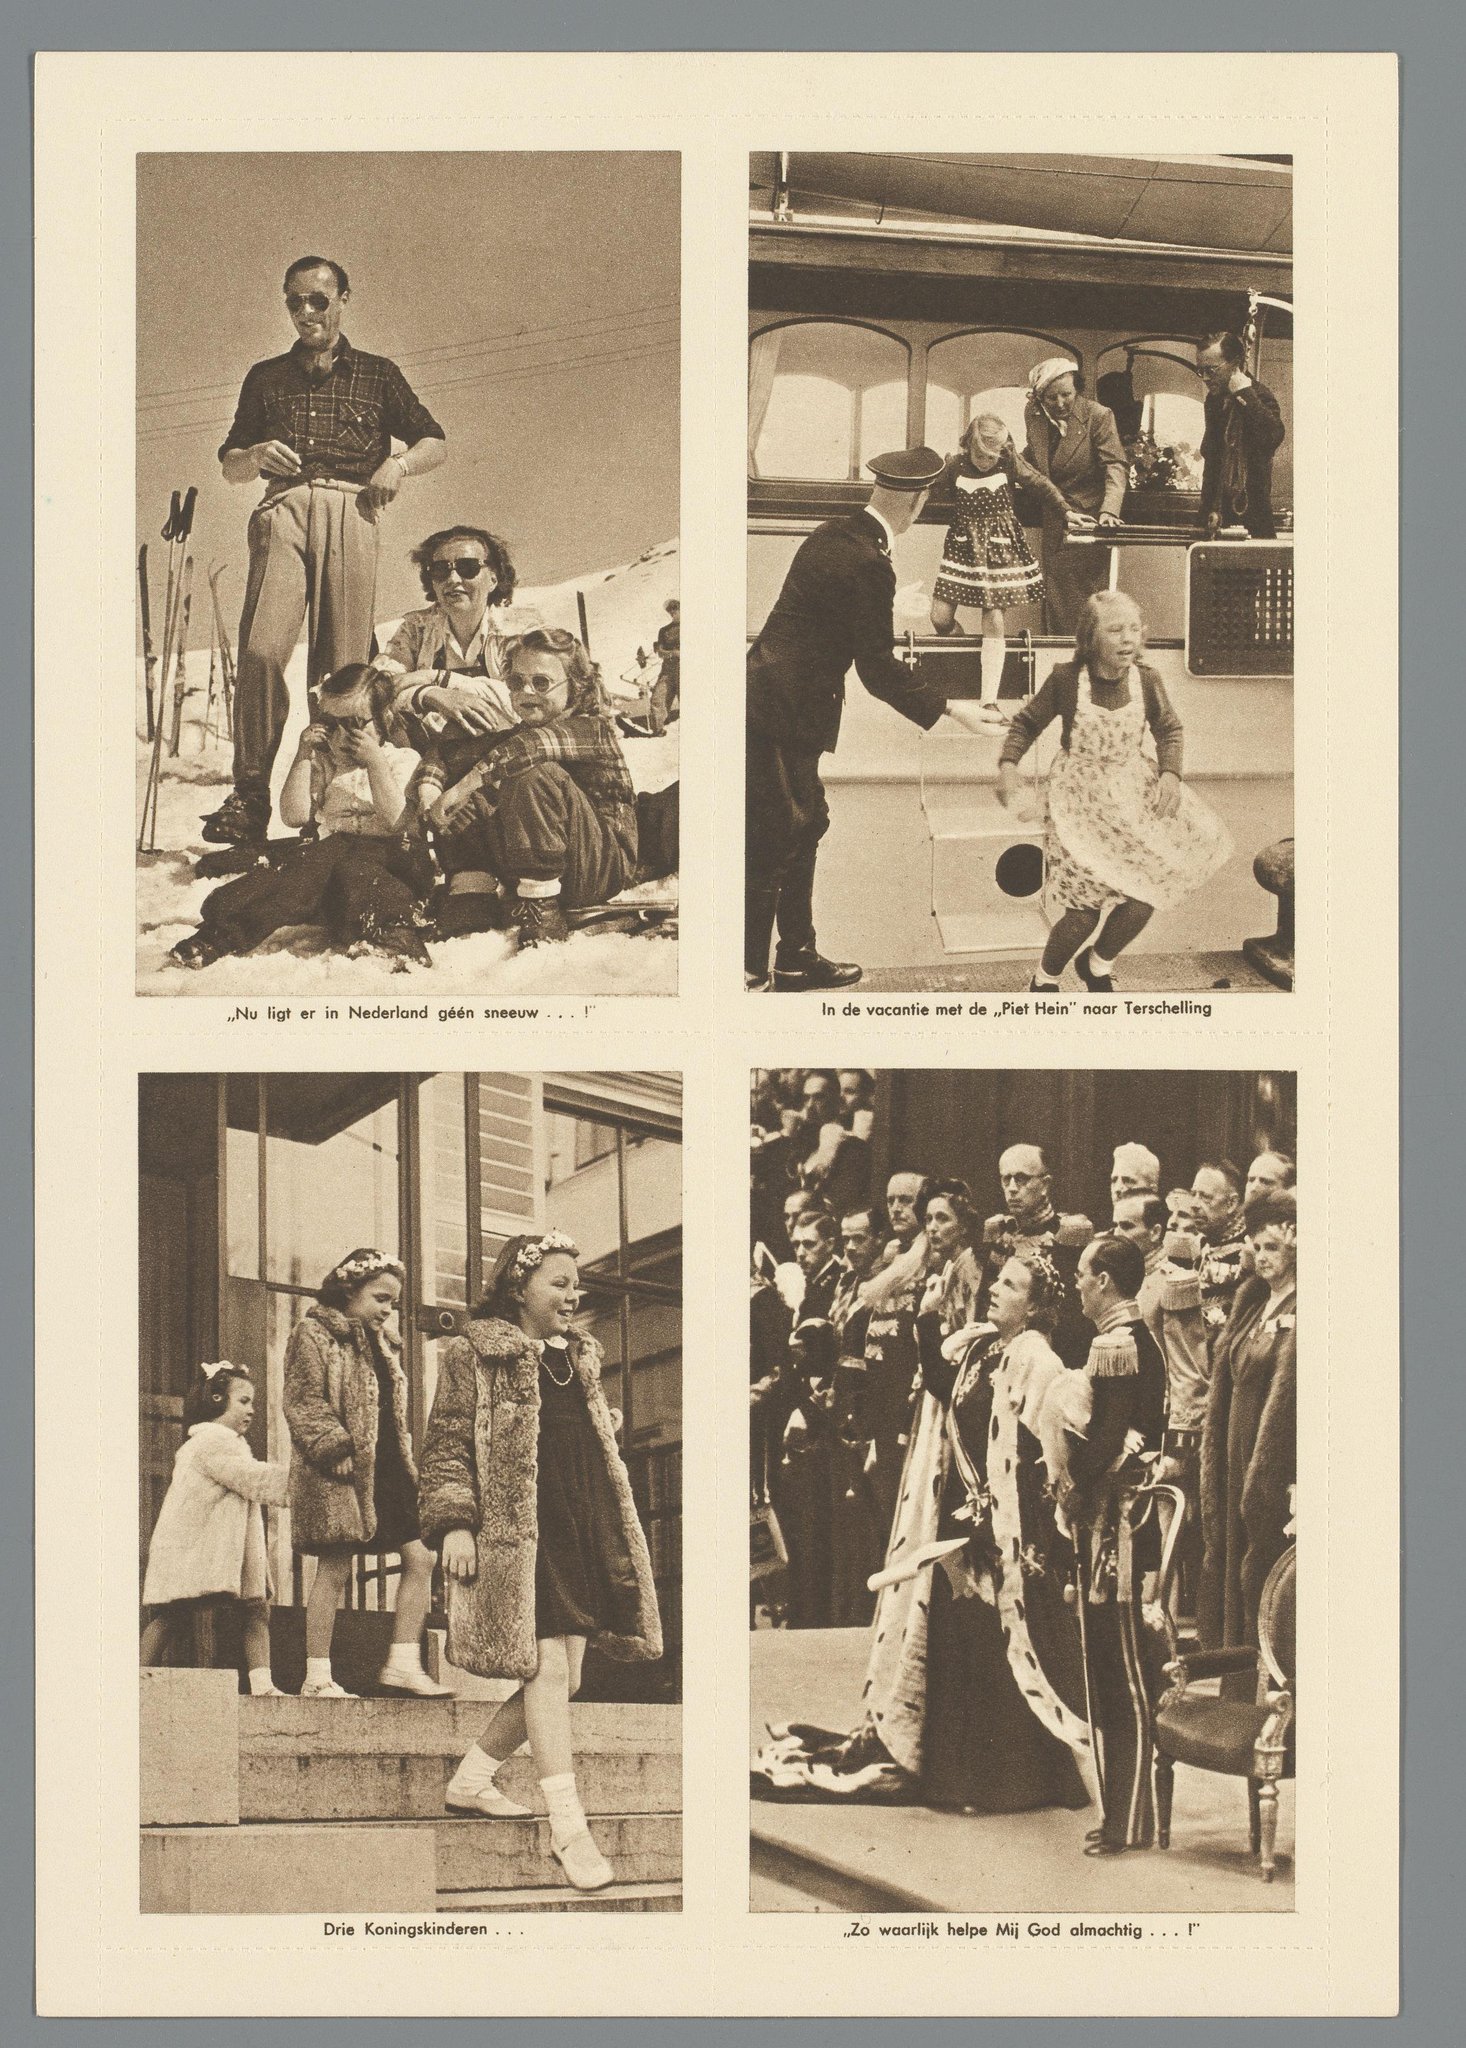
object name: photomechanical print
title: Drie Koningskinderen...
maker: Anonymous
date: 1949-1951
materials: paper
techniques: rotogravure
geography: alphen aan den rijn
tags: the hague, juliana of the netherlands, royal children, coronation of a ruler, netherlands